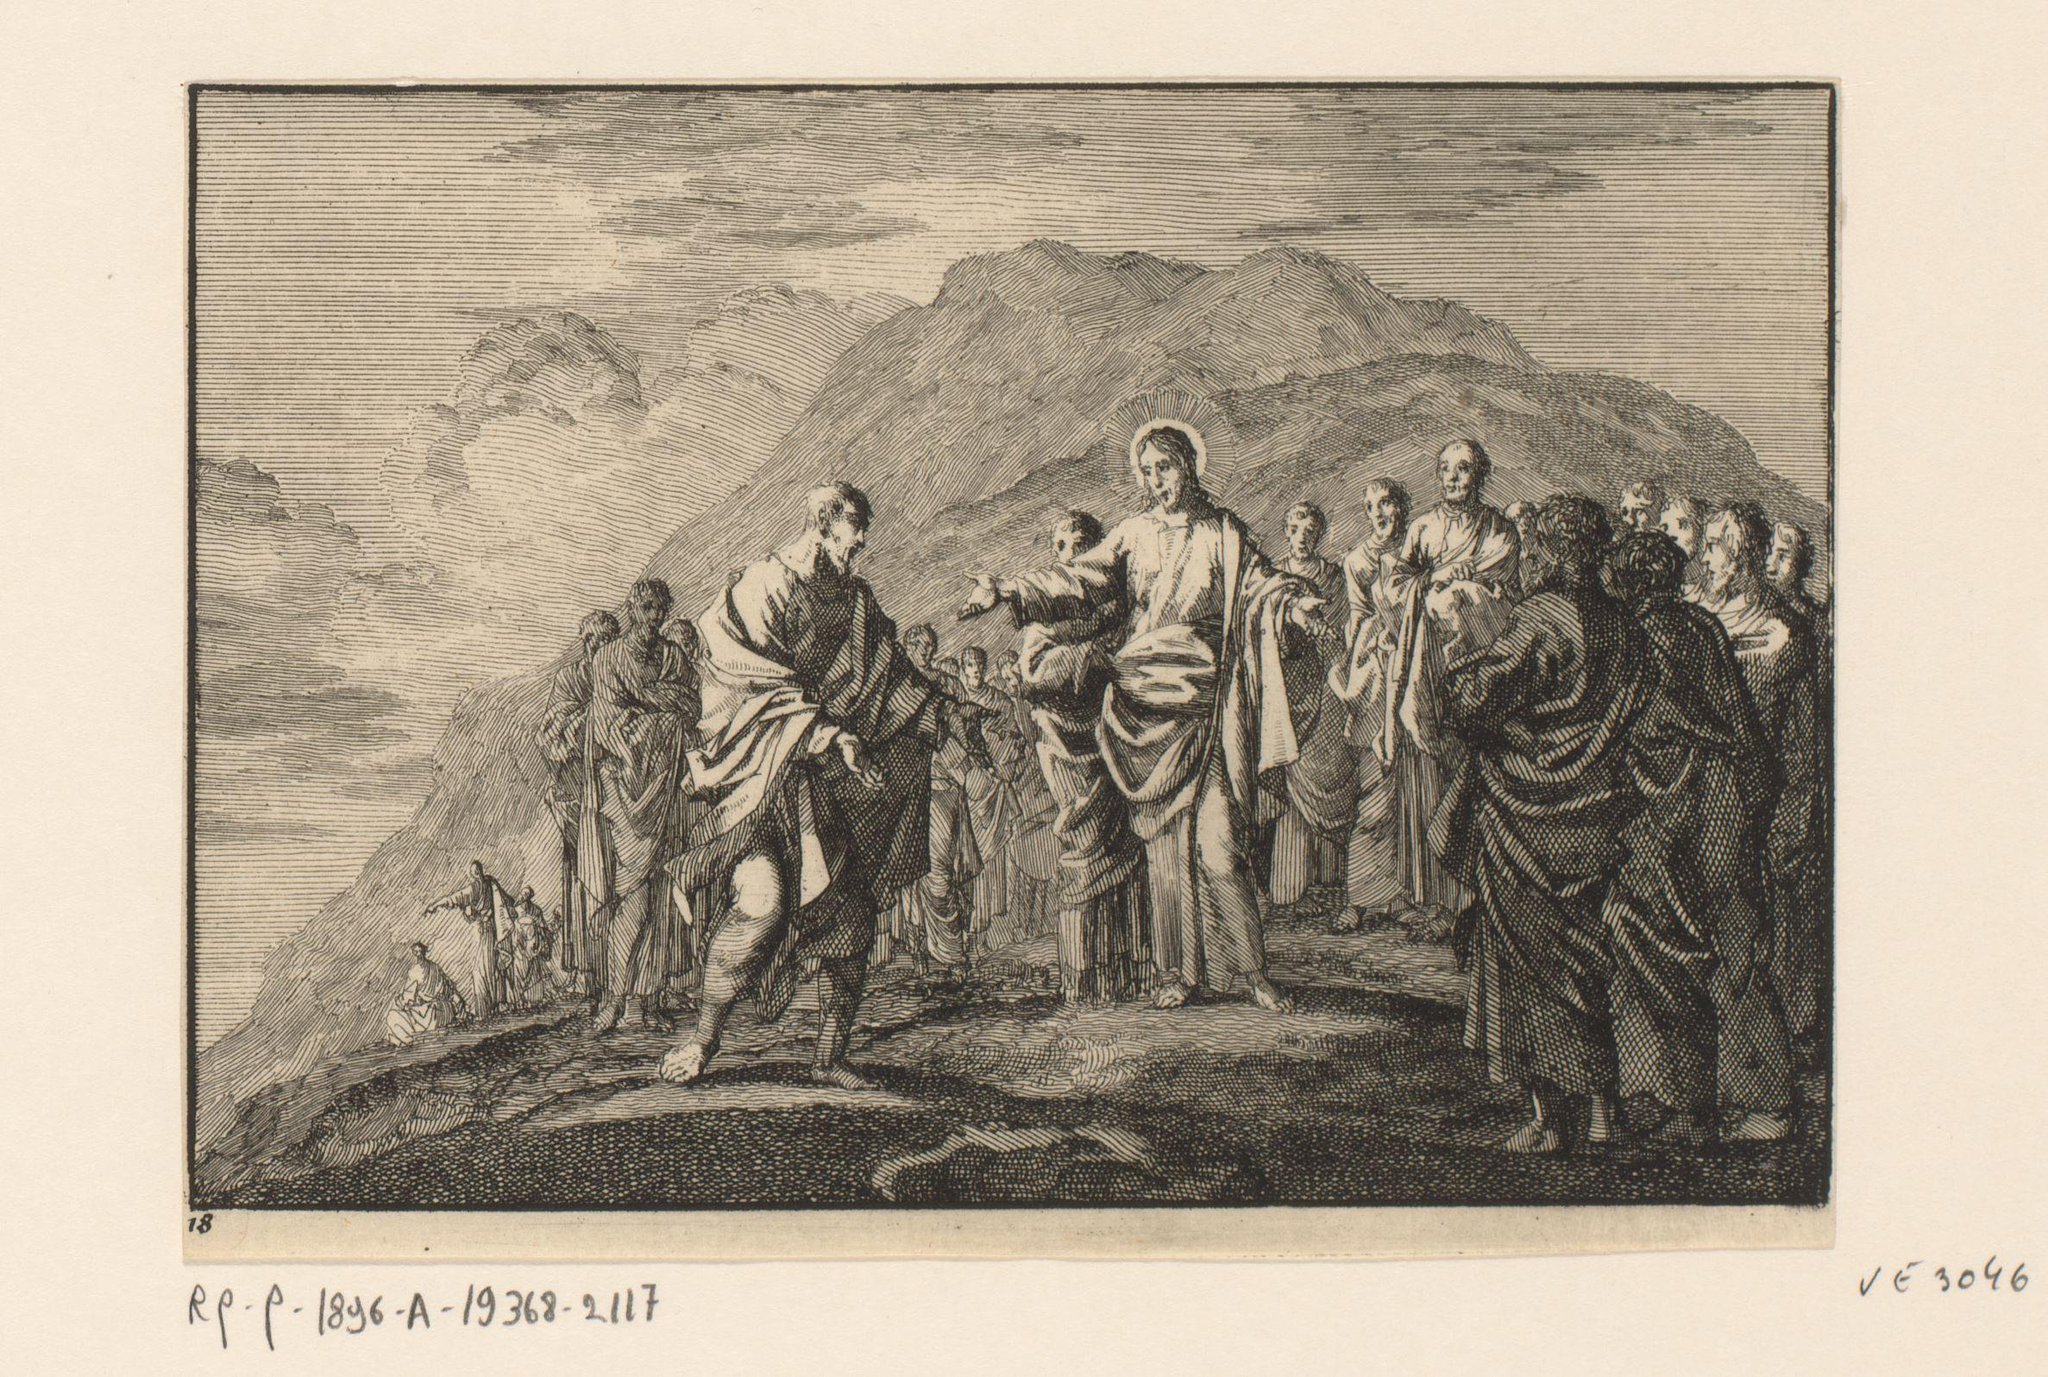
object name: print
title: Uitzending van de apostelen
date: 1703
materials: paper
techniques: etching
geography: haarlem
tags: christ sends apostles out in pairs (matthew 10:1-16; mark 6:7-11; luke 9:1-5)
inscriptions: collector's mark: Lugt 2228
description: Proefdruk van een boekillustratie voor David Martin. Historie des Ouden en Nieuwen Testaments. Amsterdam, Pieter Mortier, 1703. Deel II. De boekillustraties voor de Mortierbijbel hebben verschillende staten en kopieën, waarbij de chronologische volgorde moeilijk te achterhalen valt. Als boekillustraties werden ze bovendien herhaaldelijk opnieuw gebruikt voor andere boekwerken.